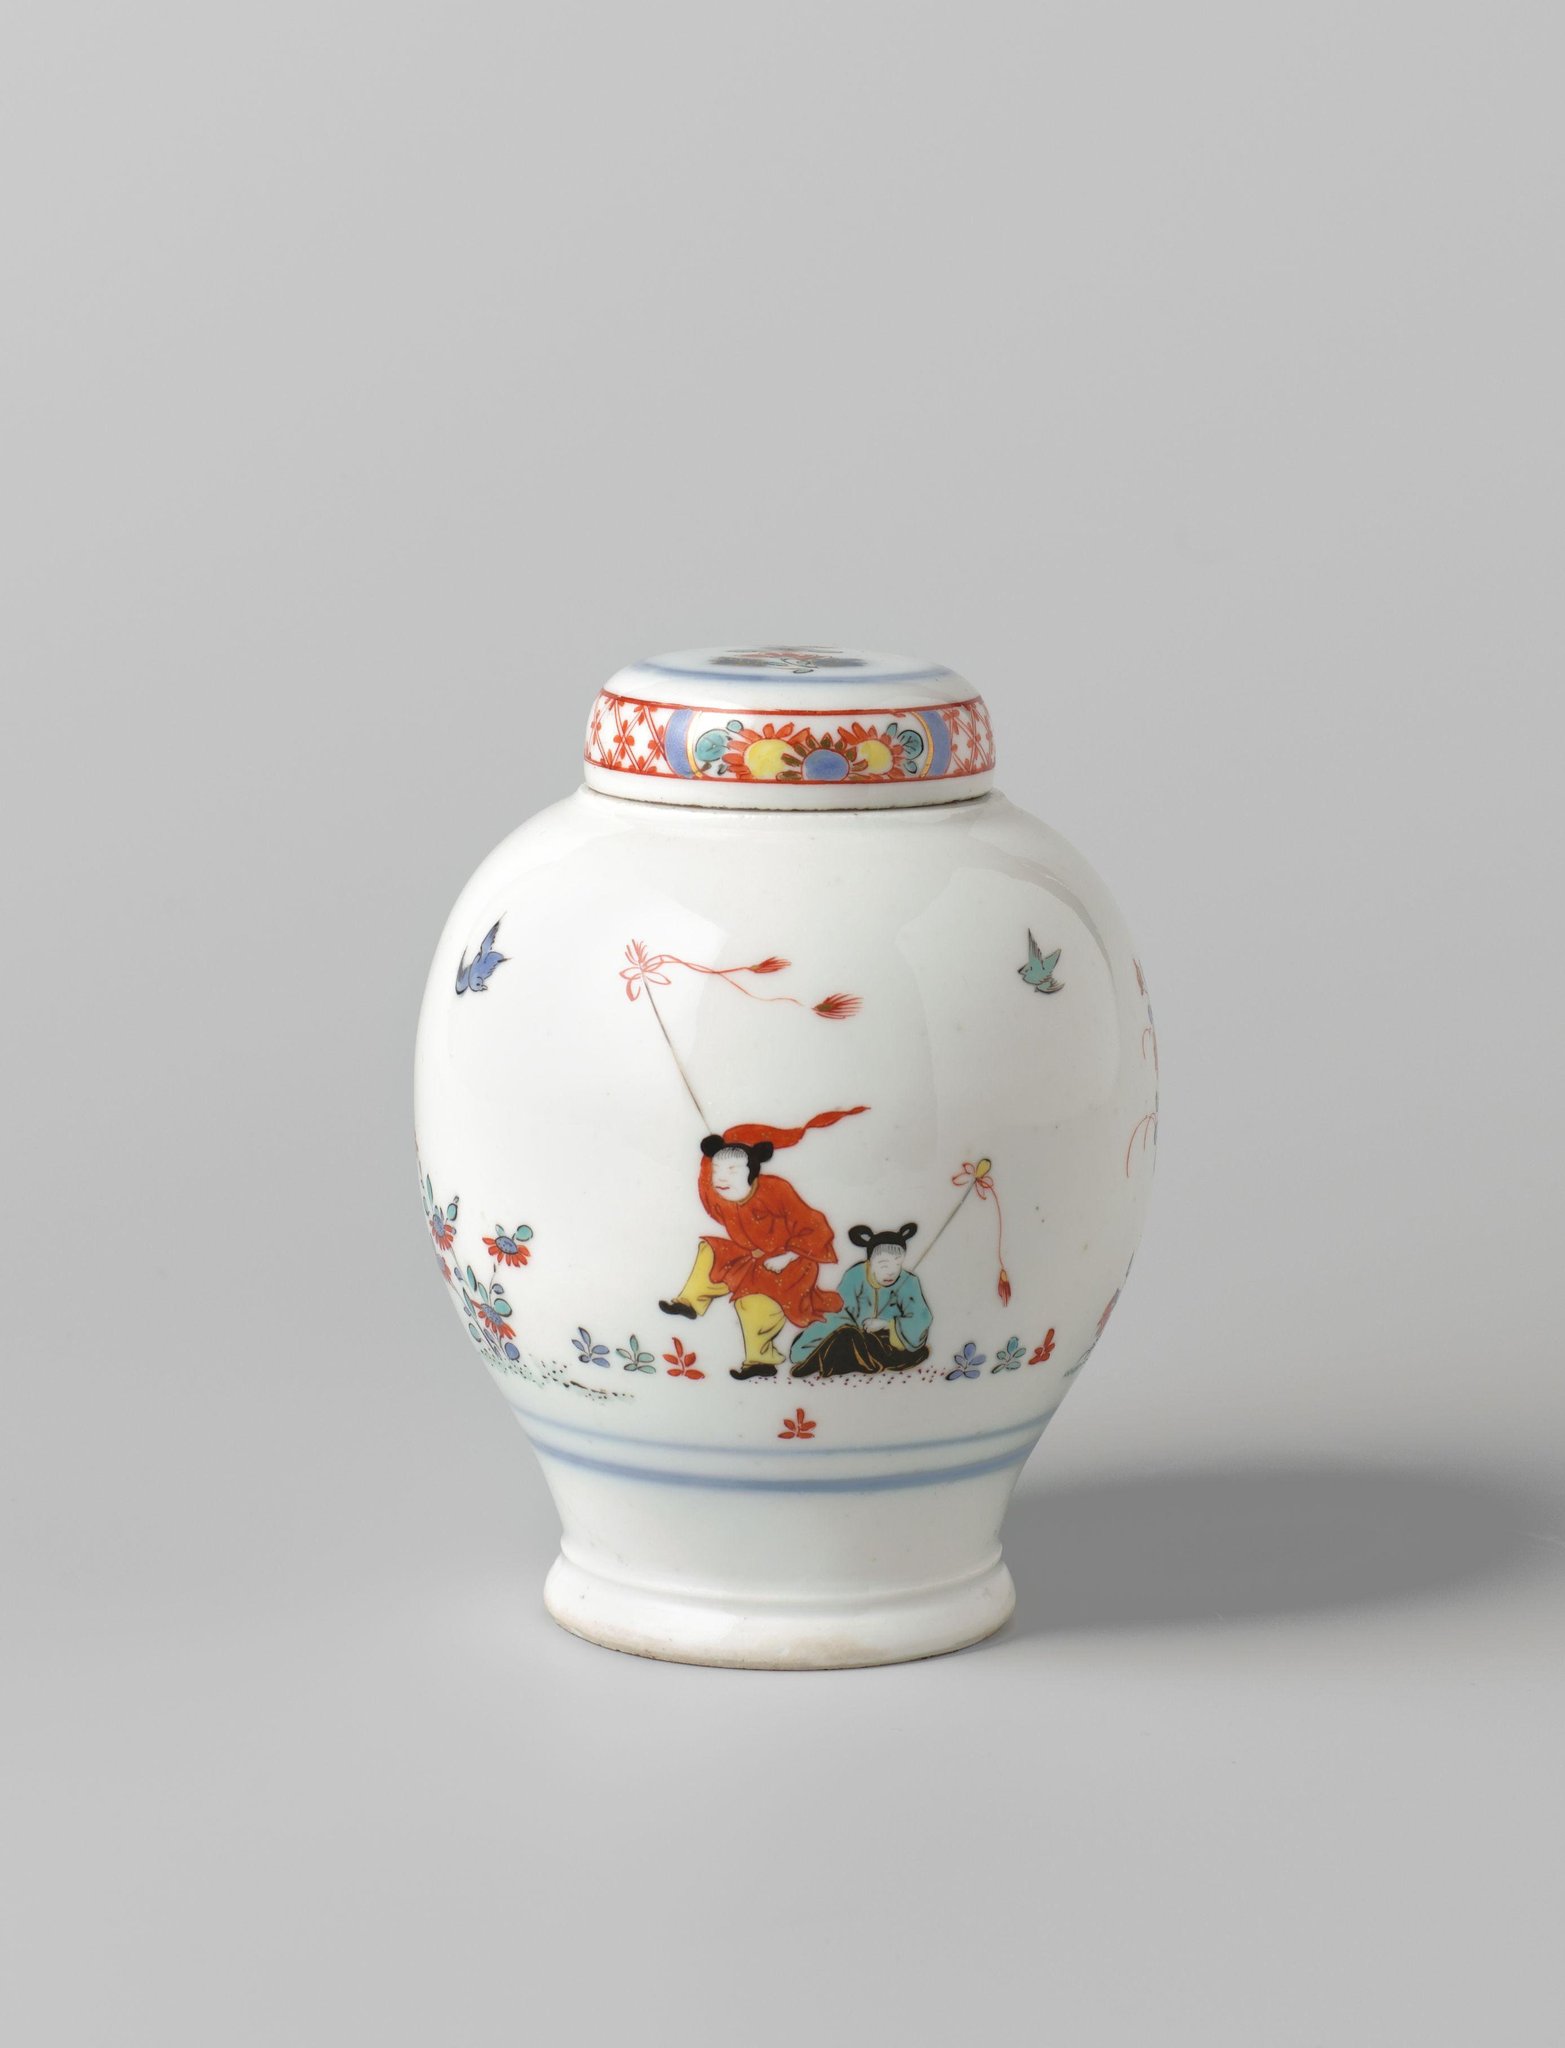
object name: lid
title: Deksel van theebus, veelkleurig beschilderd met chinoiserieën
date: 1730-1735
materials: porcelain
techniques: painted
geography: meissen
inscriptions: mold mark: ‘X (Rückert 1996, afb. 6, nr. 33)’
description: Deksel van theebus van beschilderd porselein.